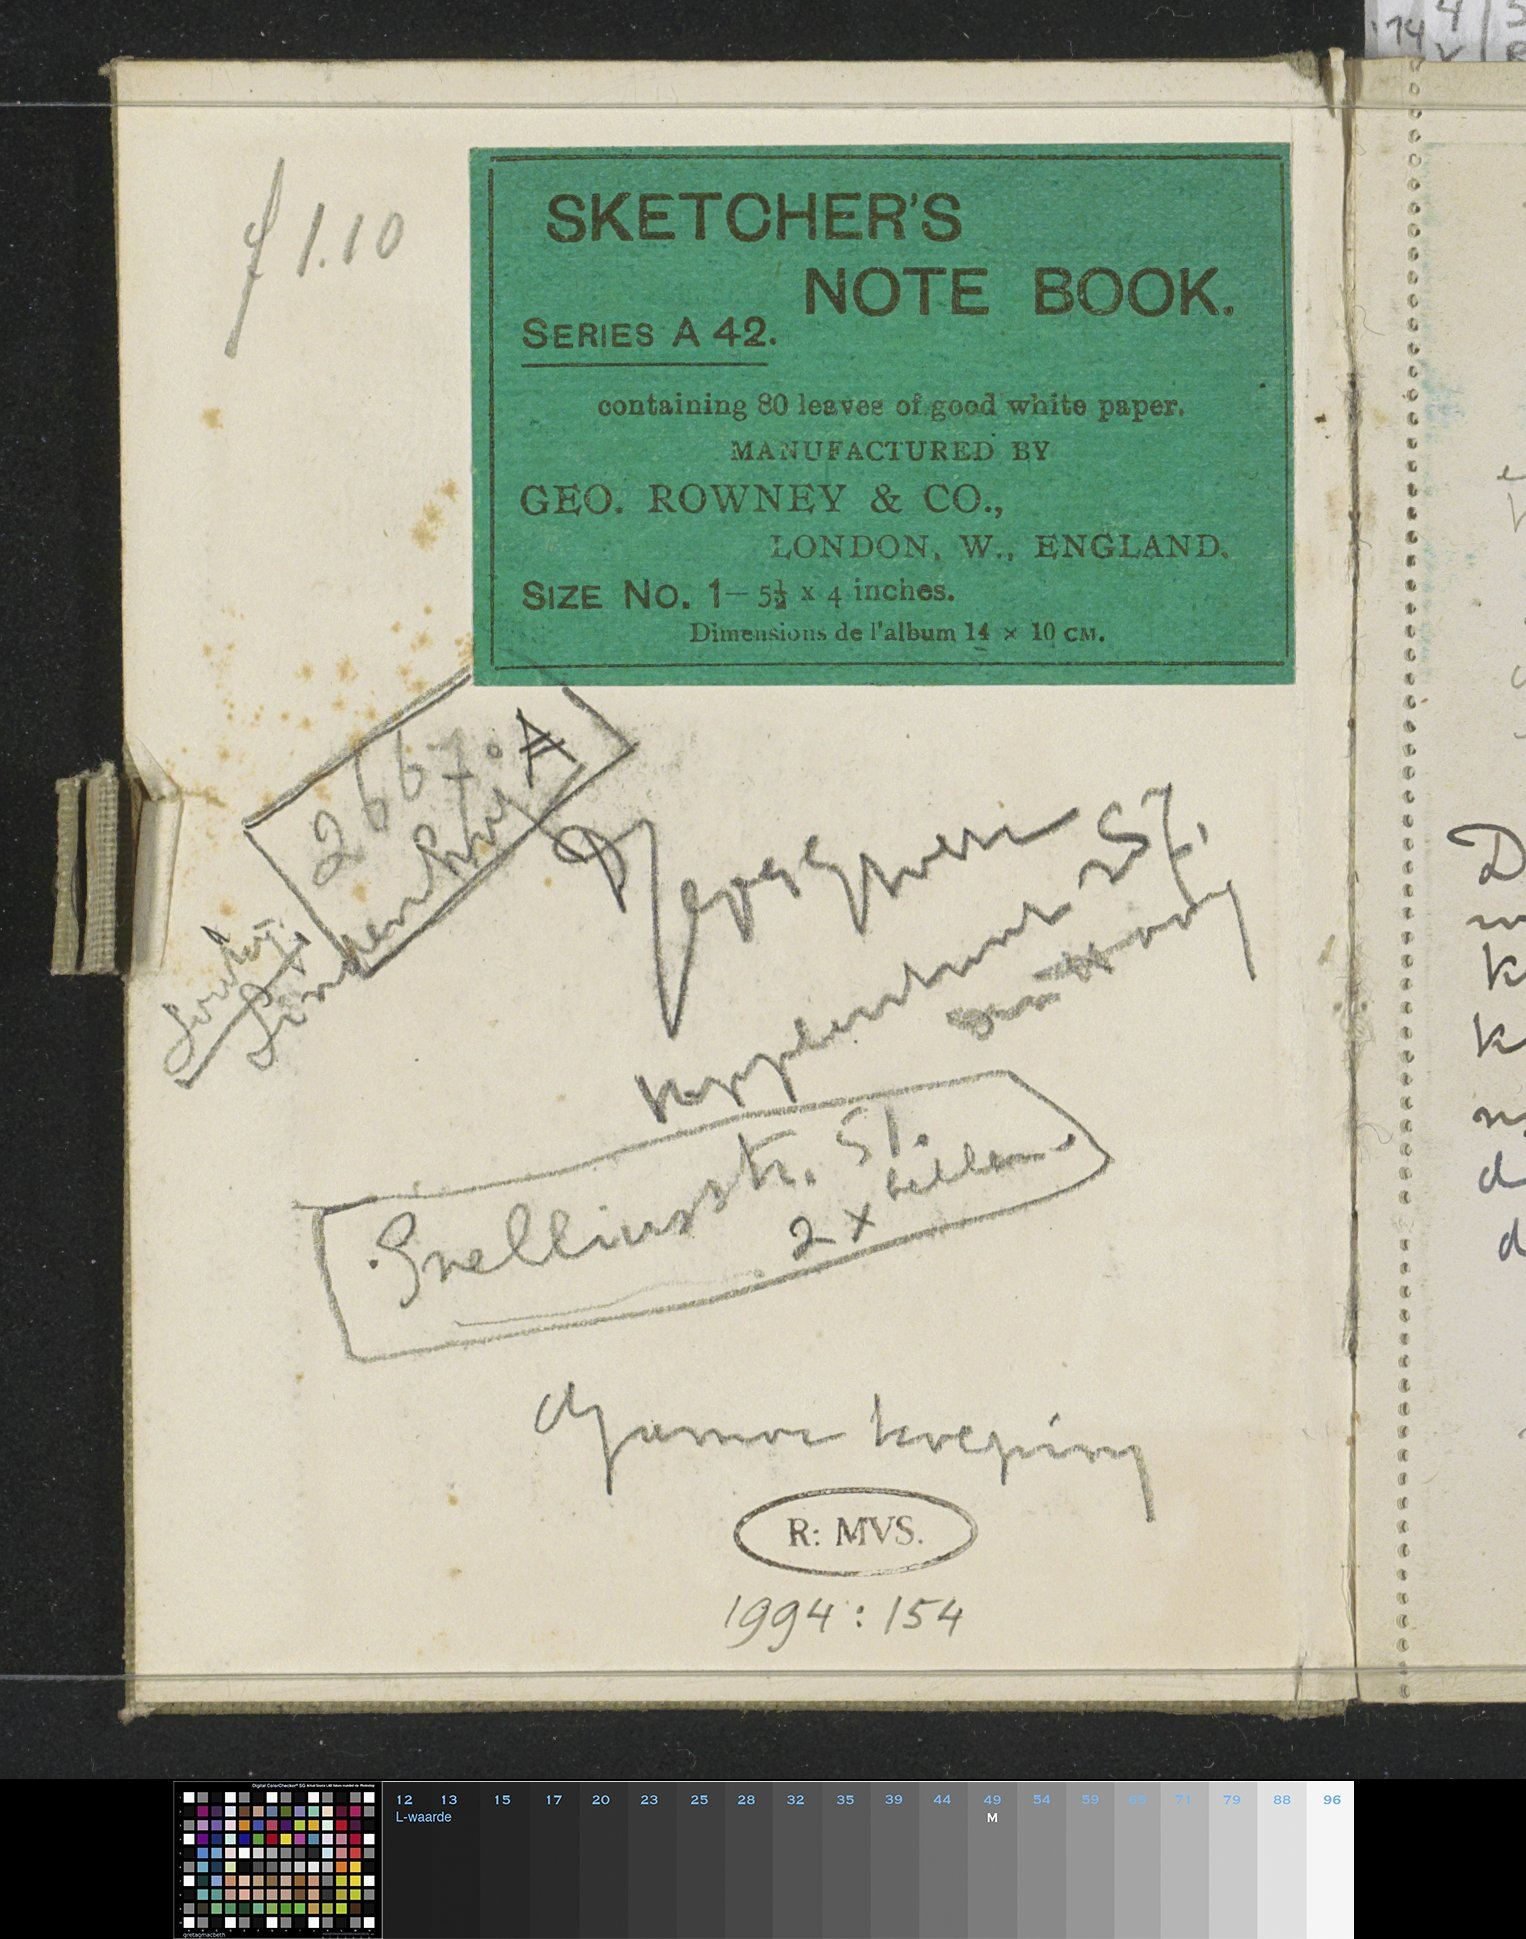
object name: sketchbook leaf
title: Notities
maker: reijer stolk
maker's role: draughtsman, print maker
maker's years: 1896-1945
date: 1906-1945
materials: paper, pencil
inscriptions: factory mark: ‘SKETCHER’S/ NOTE BOOK/ SERIES A 42./ containing 80 leaves of good white paper./ MANUFACTURED BY/ GEO. ROWNEY 7 Co.,/ LONDON, W., ENGLAND./ SIZE No. 1 – 5 ½ x 4 inches./ Dimensions de l’album 14 x 10 CM.’, collector's mark: Lugt 2228a, annotation: ‘f 1.10/ 2667/ [...] Lindenhof A/ [...]groen/ [...]oppenbuurt 257/ Den Haag/ Snelliusstr. 51/ 2 x [...]/ [...]’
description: Voorste schutblad uit een schetsboek met 53 bladen.